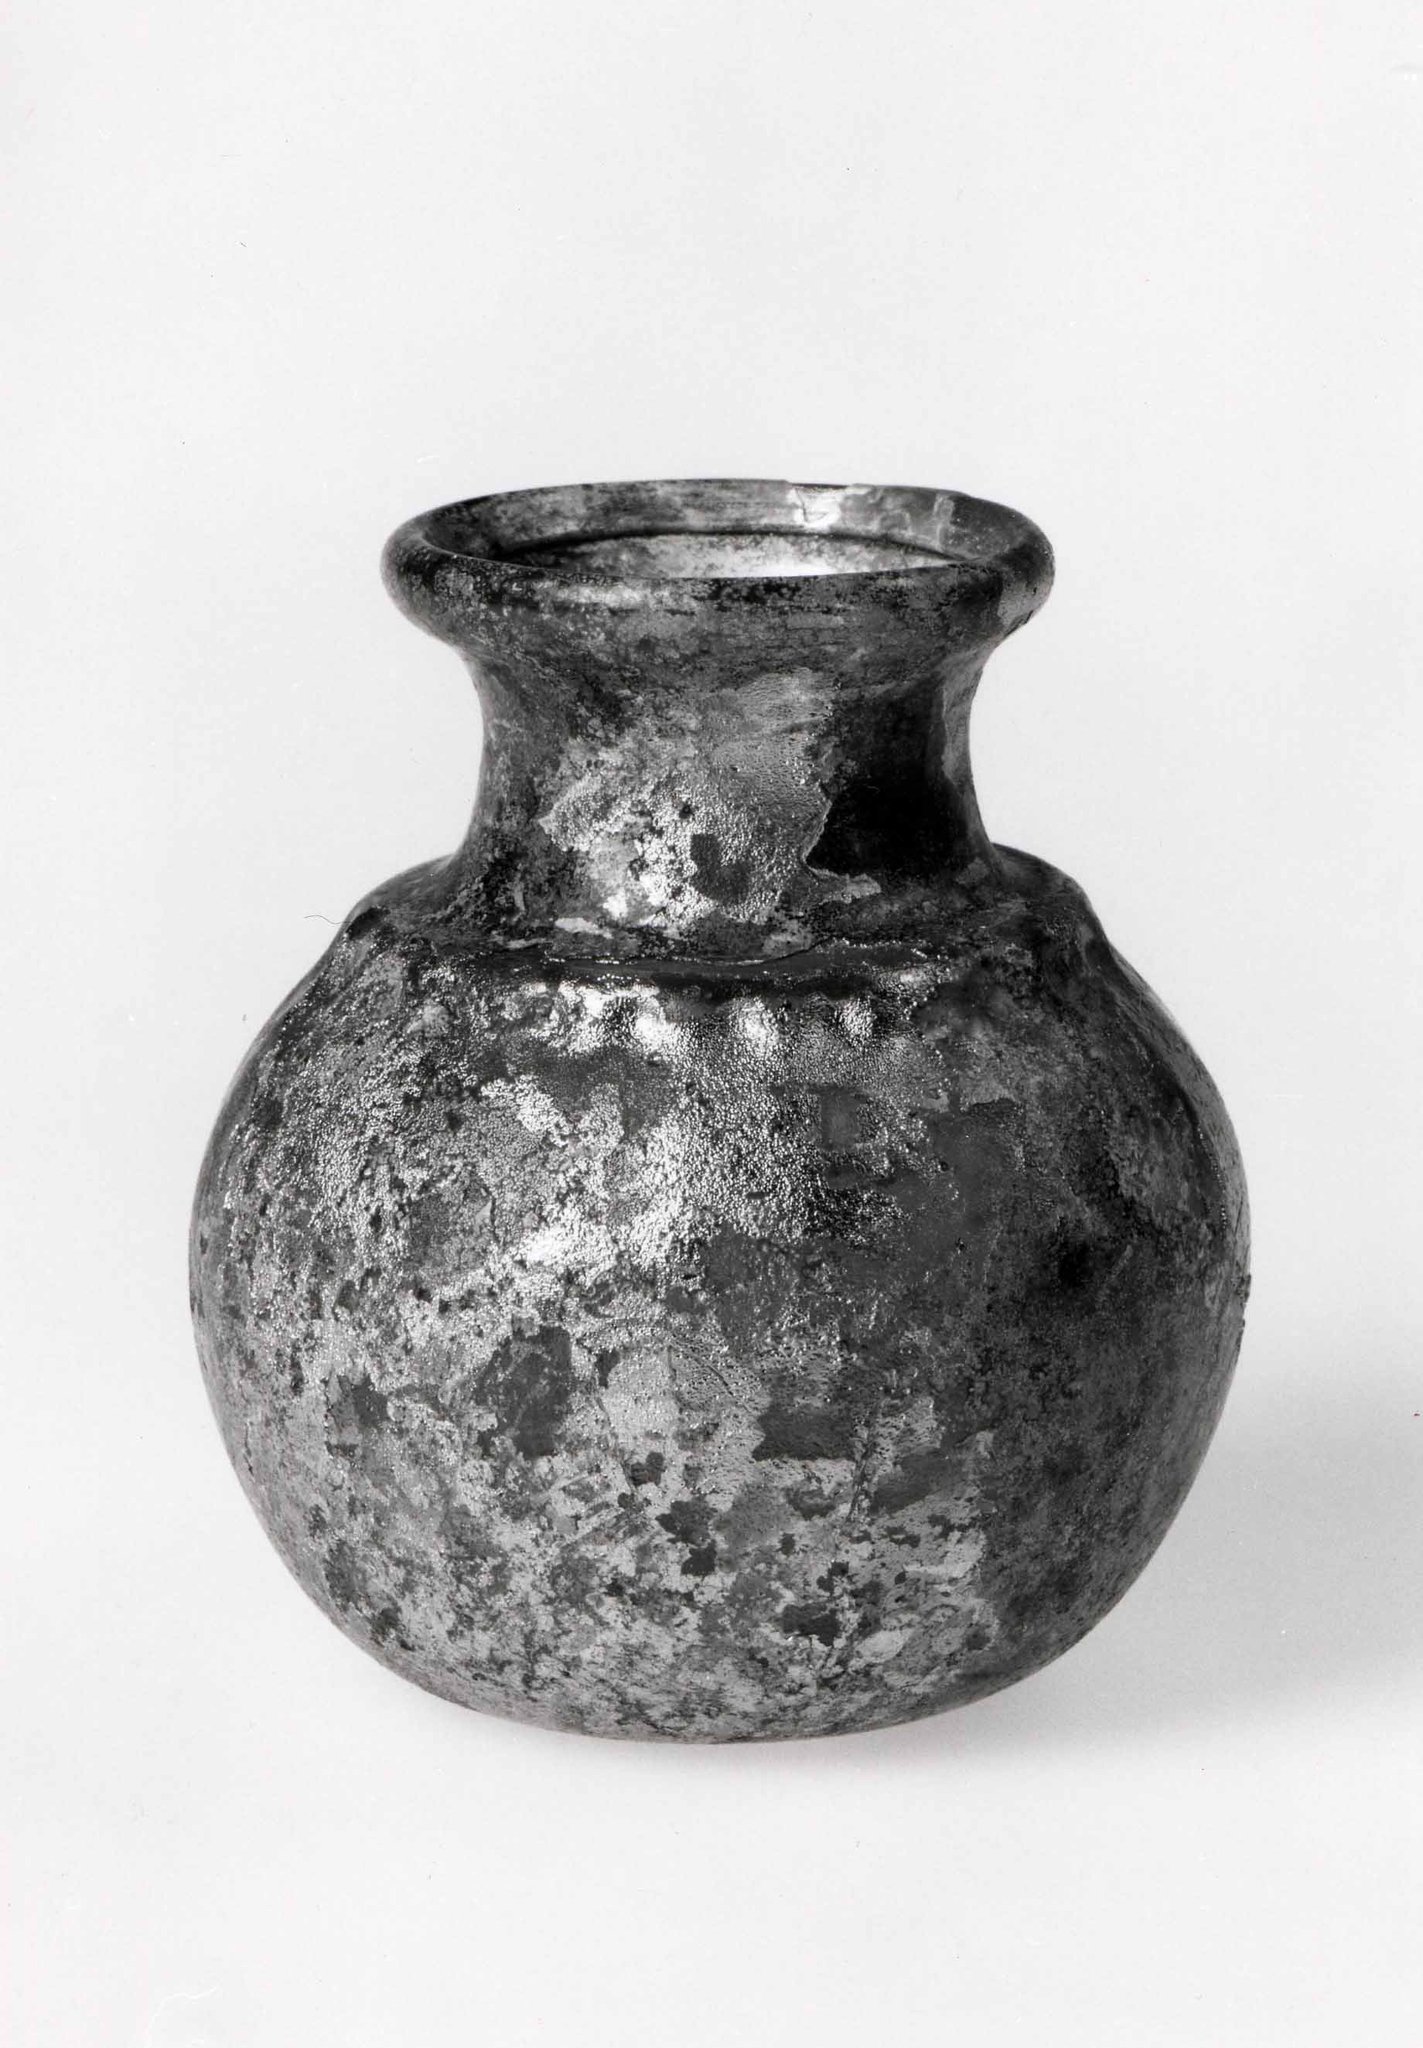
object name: jar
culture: roman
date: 301-400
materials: glass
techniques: glassblowing